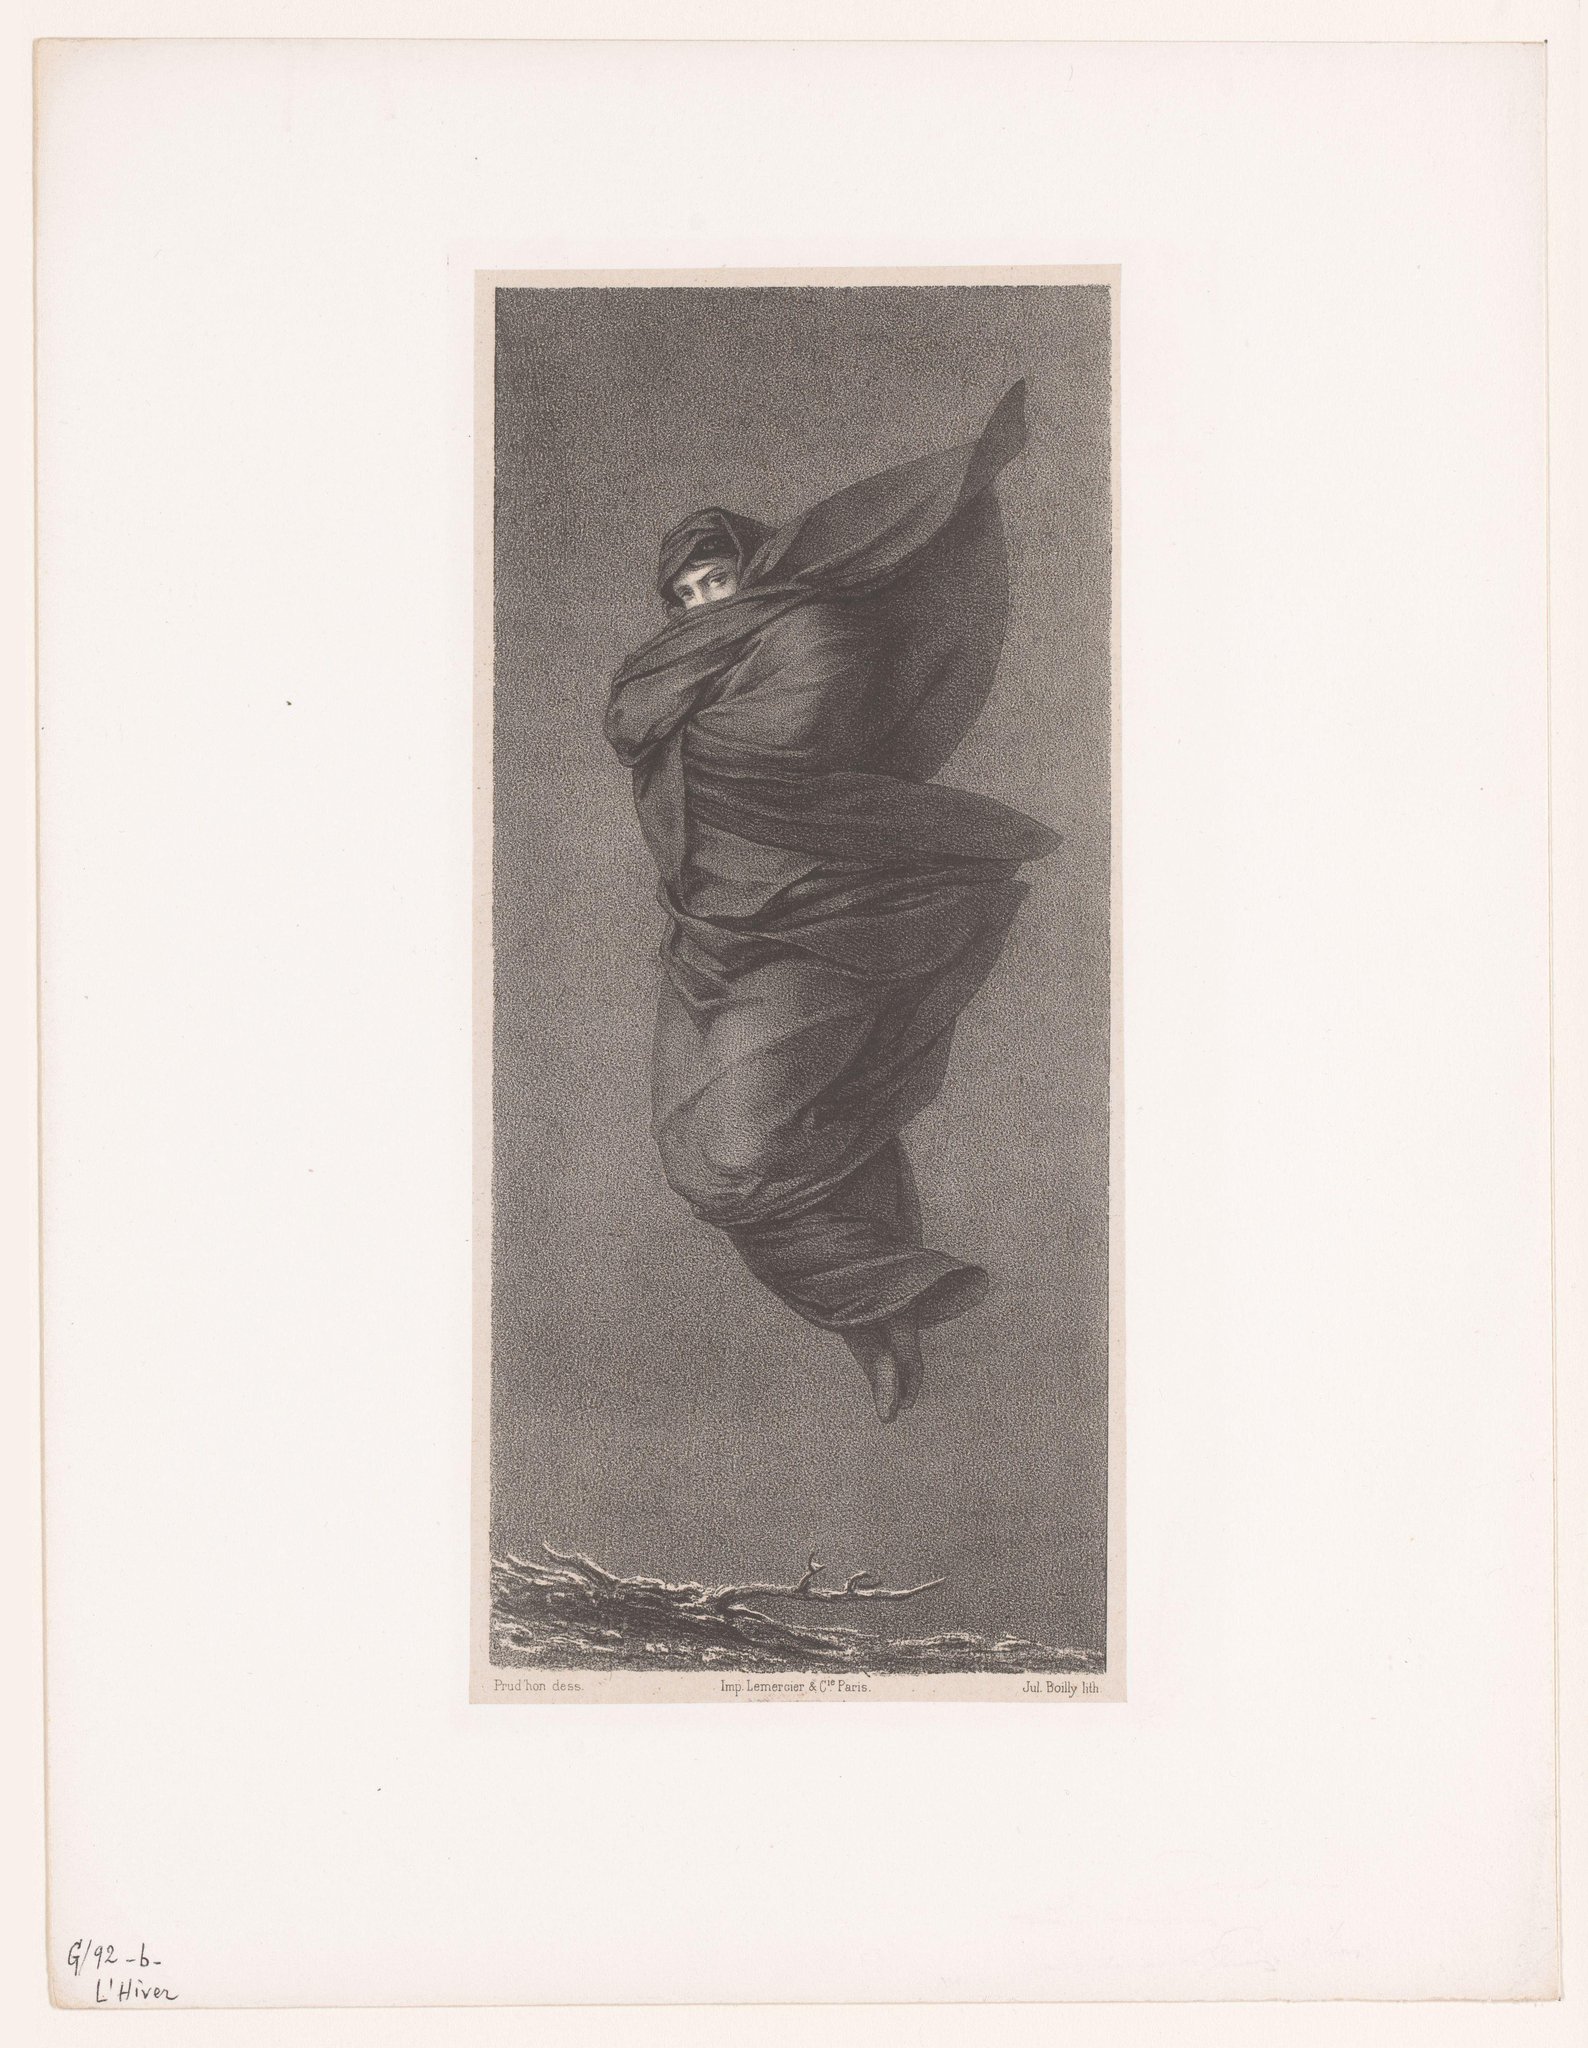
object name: print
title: Vier seizoenen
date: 1811-1867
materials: paper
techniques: lithograph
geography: paris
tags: winter, 'hyems'; 'inverno' (ripa)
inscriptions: collector's mark: Lugt 2228, collector's mark: Lugt 2760